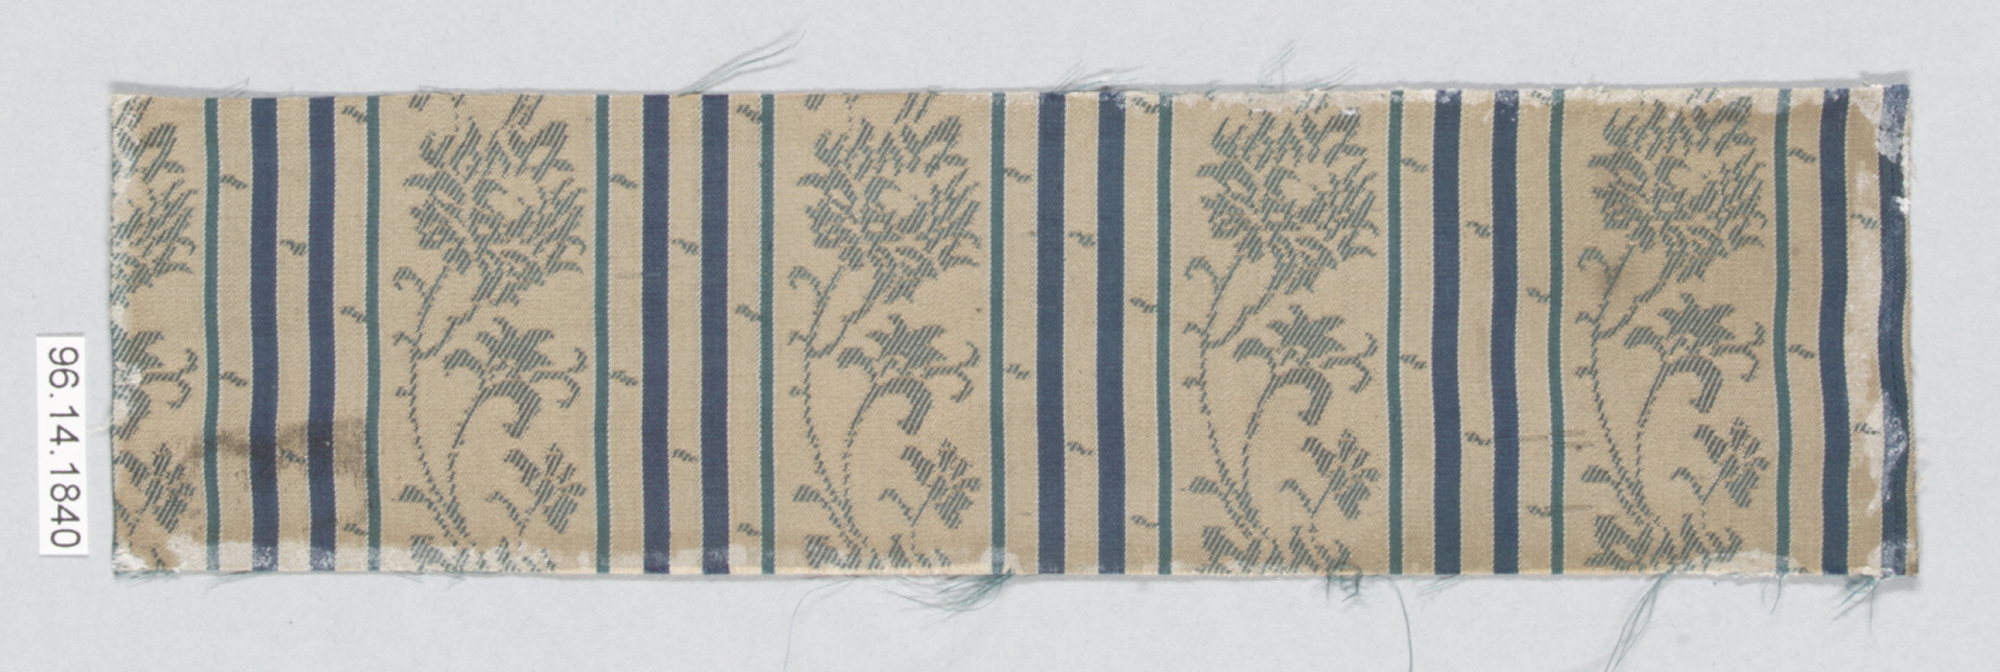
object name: piece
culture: japanese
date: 1701-1800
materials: silk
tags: flowers